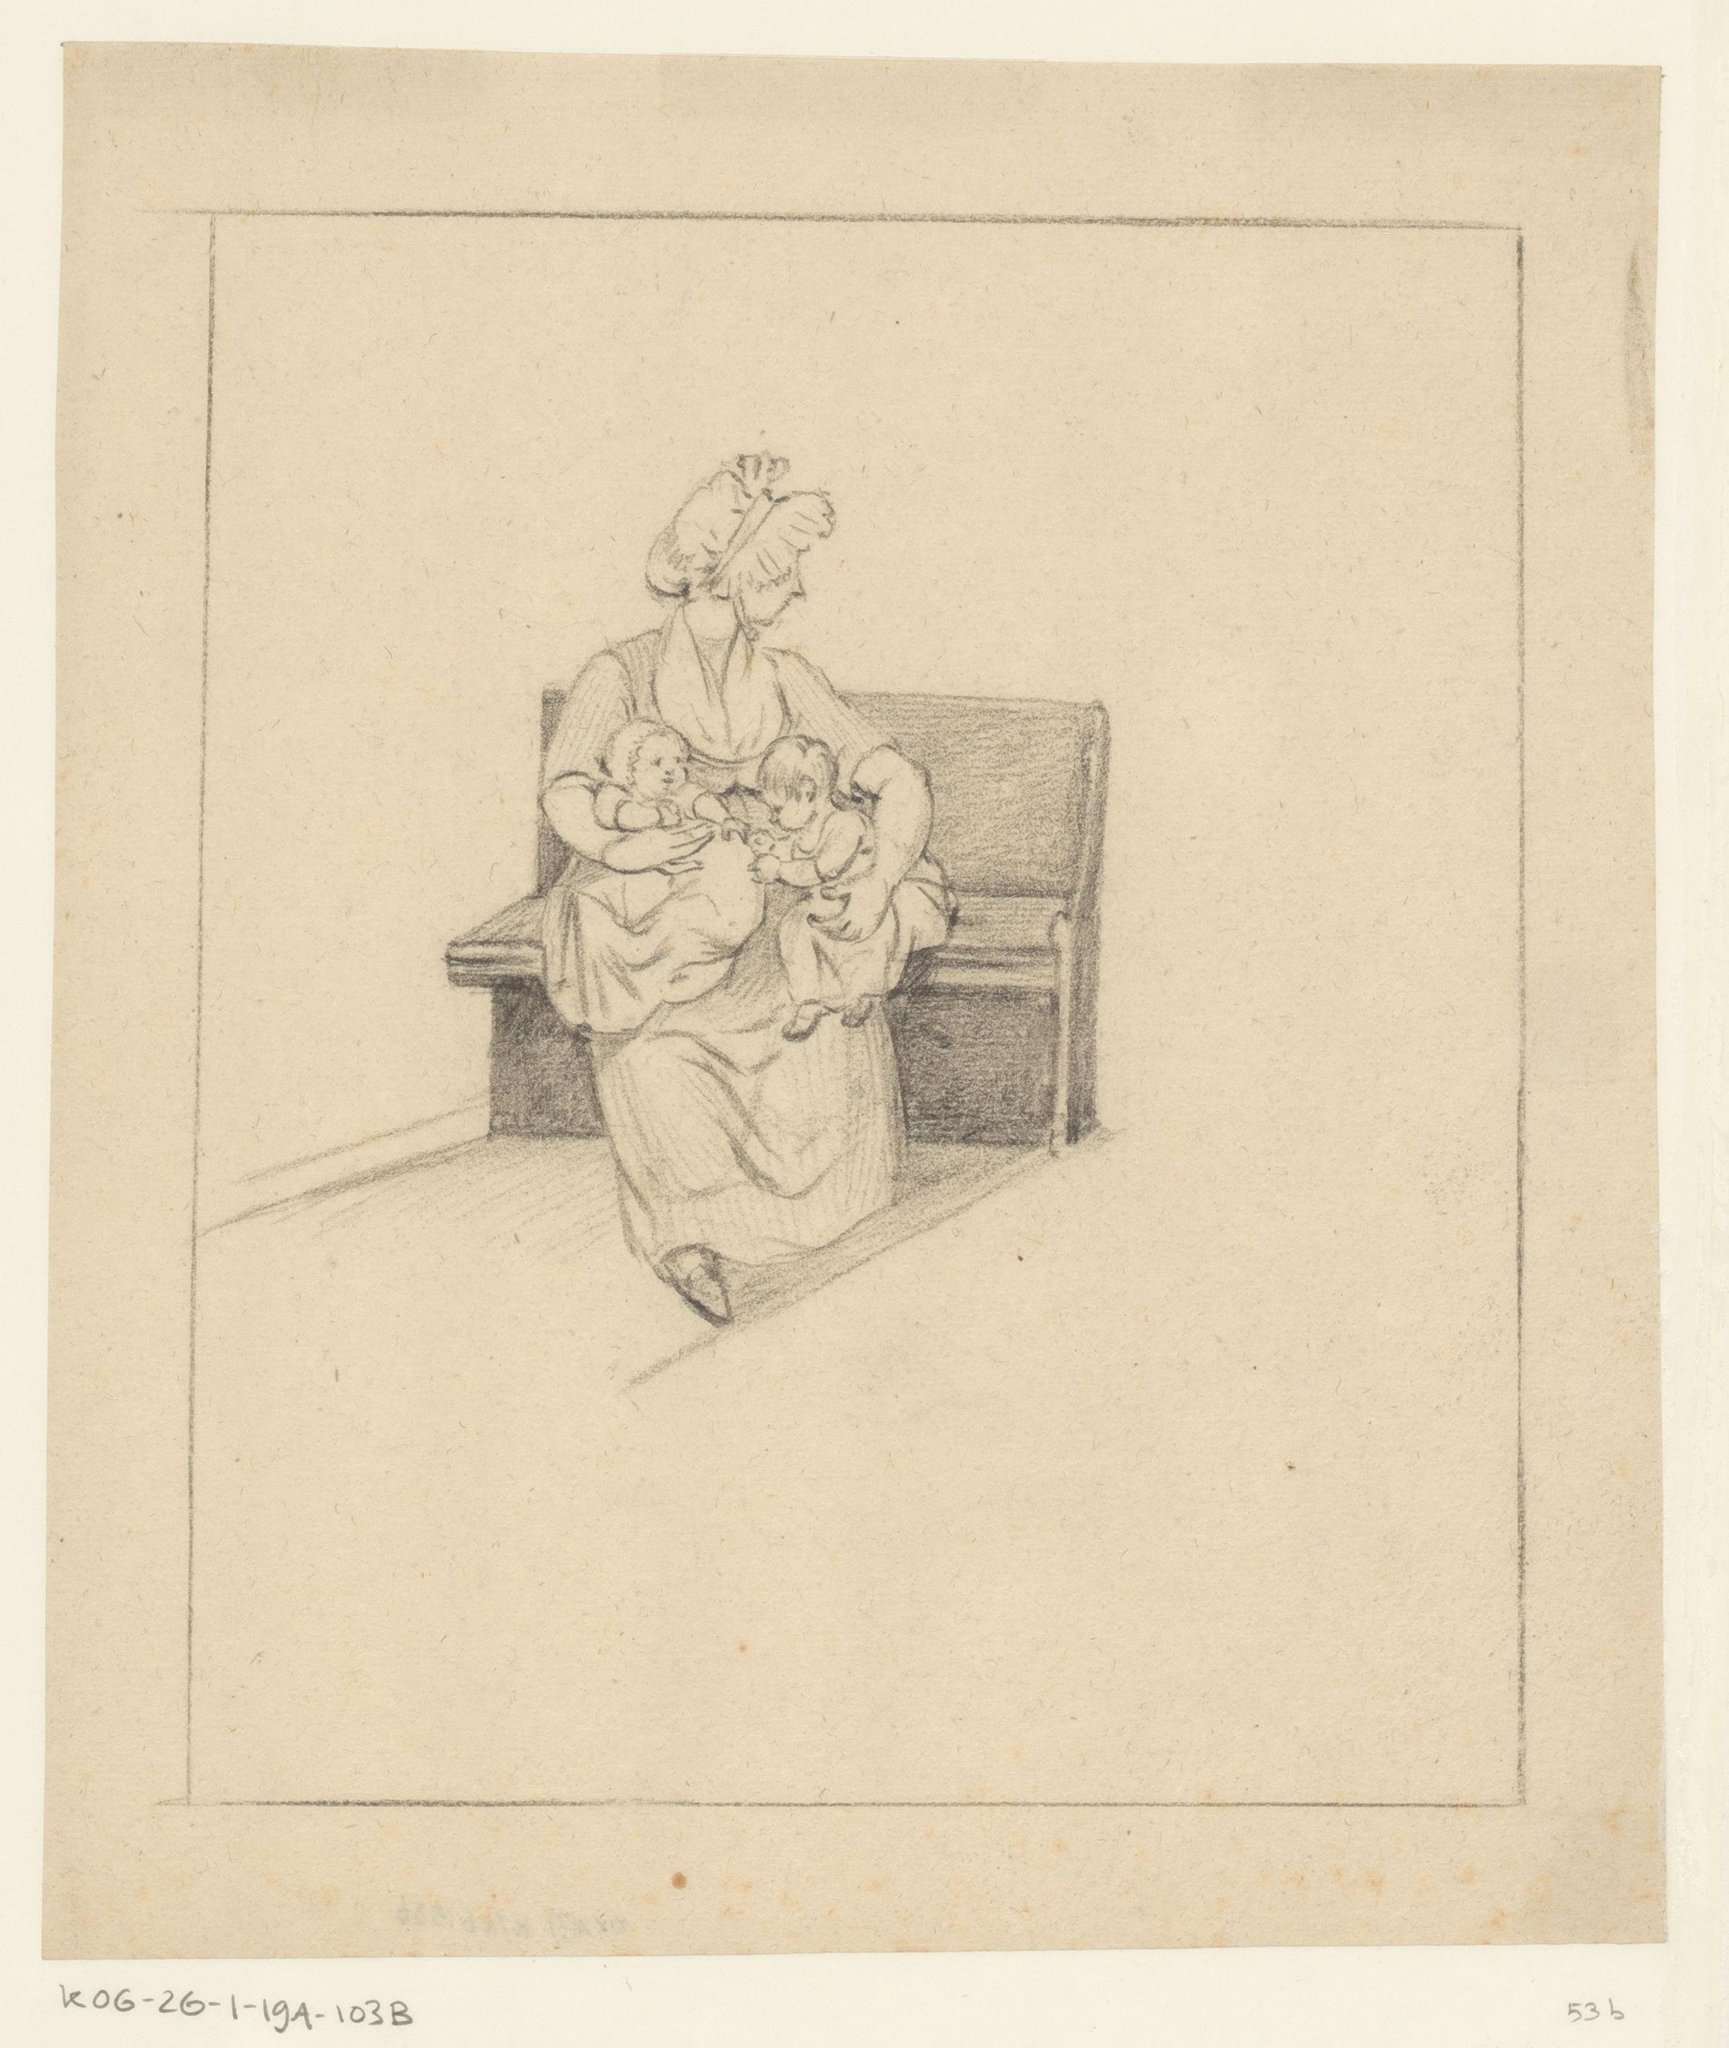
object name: drawing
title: Moeder met twee kinderen op schoot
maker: Anonymous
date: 1800-1899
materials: paper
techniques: black chalk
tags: mother and baby or young child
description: Onderwerpsrubrieken binnen de Atlas Zeden en Gewoonten: Zeden en Gewoonten in Engeren Zin, Des menschen beging, midden en einde, Kinderleven – Kinderspel en Kinderprenten.